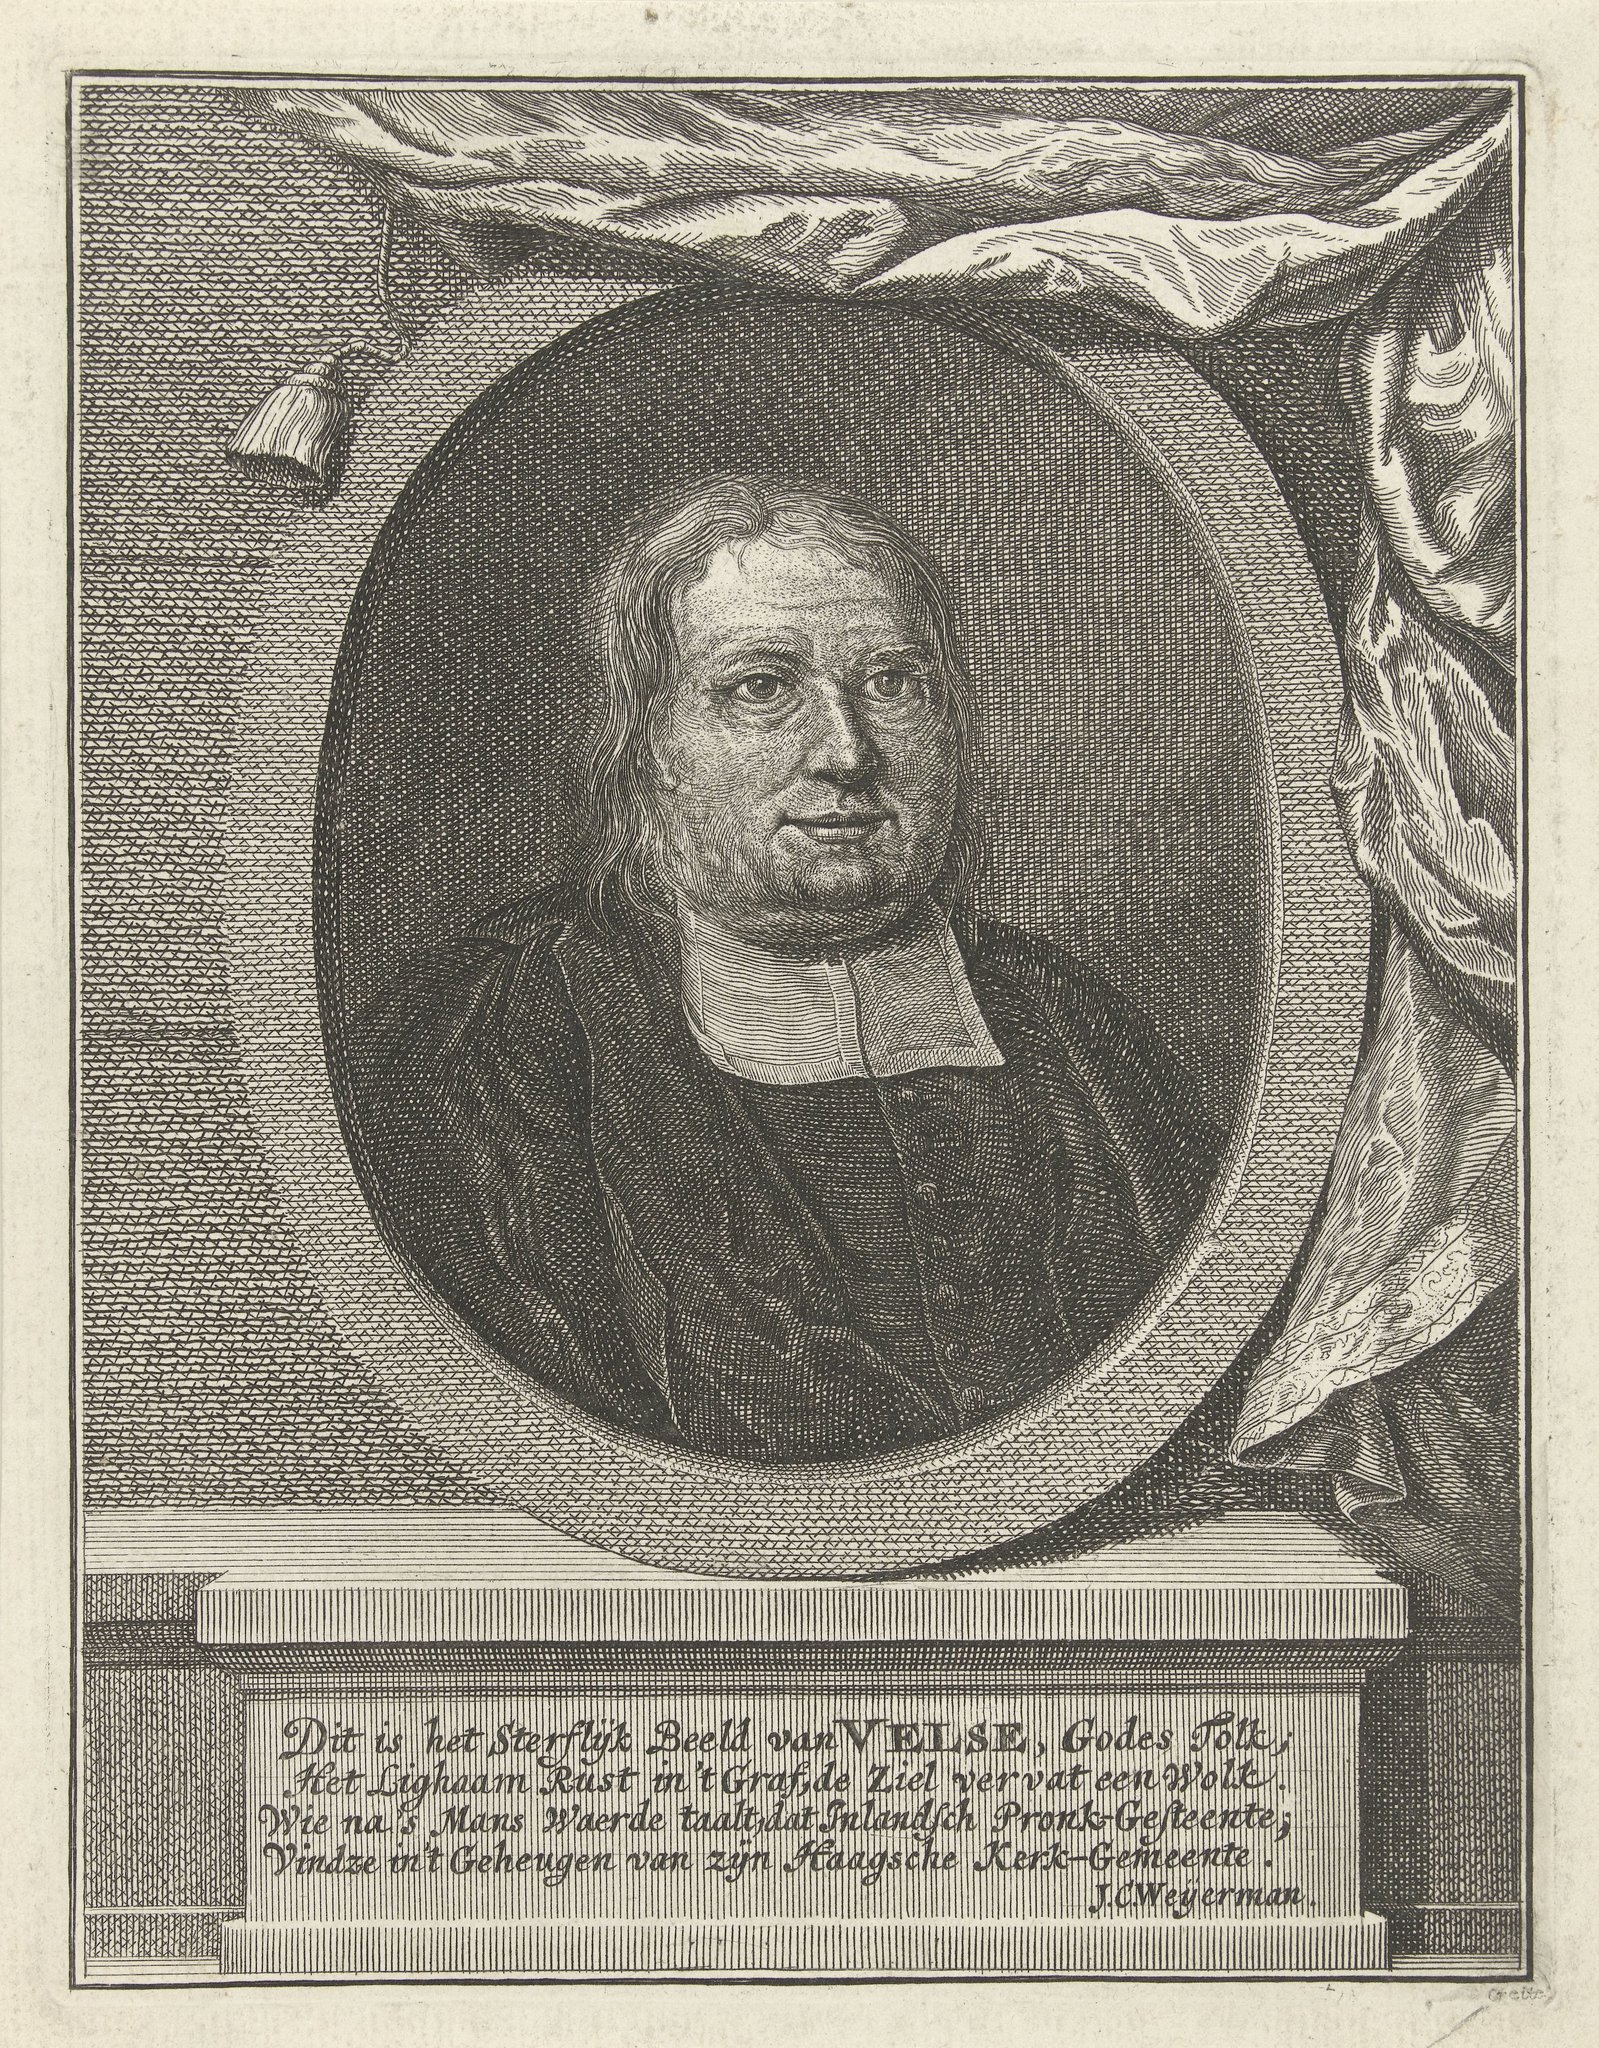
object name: print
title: Portret van Henricus Velsen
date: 1744-1765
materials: paper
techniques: etching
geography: northern netherlands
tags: predikant, henricus velse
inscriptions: collector's mark: Lugt 2228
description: Portret in ovale lijst van de Haagse predikant Henricus Velsen. Buste naar links. De prent heeft een Nederlands grafschrift op rijm.